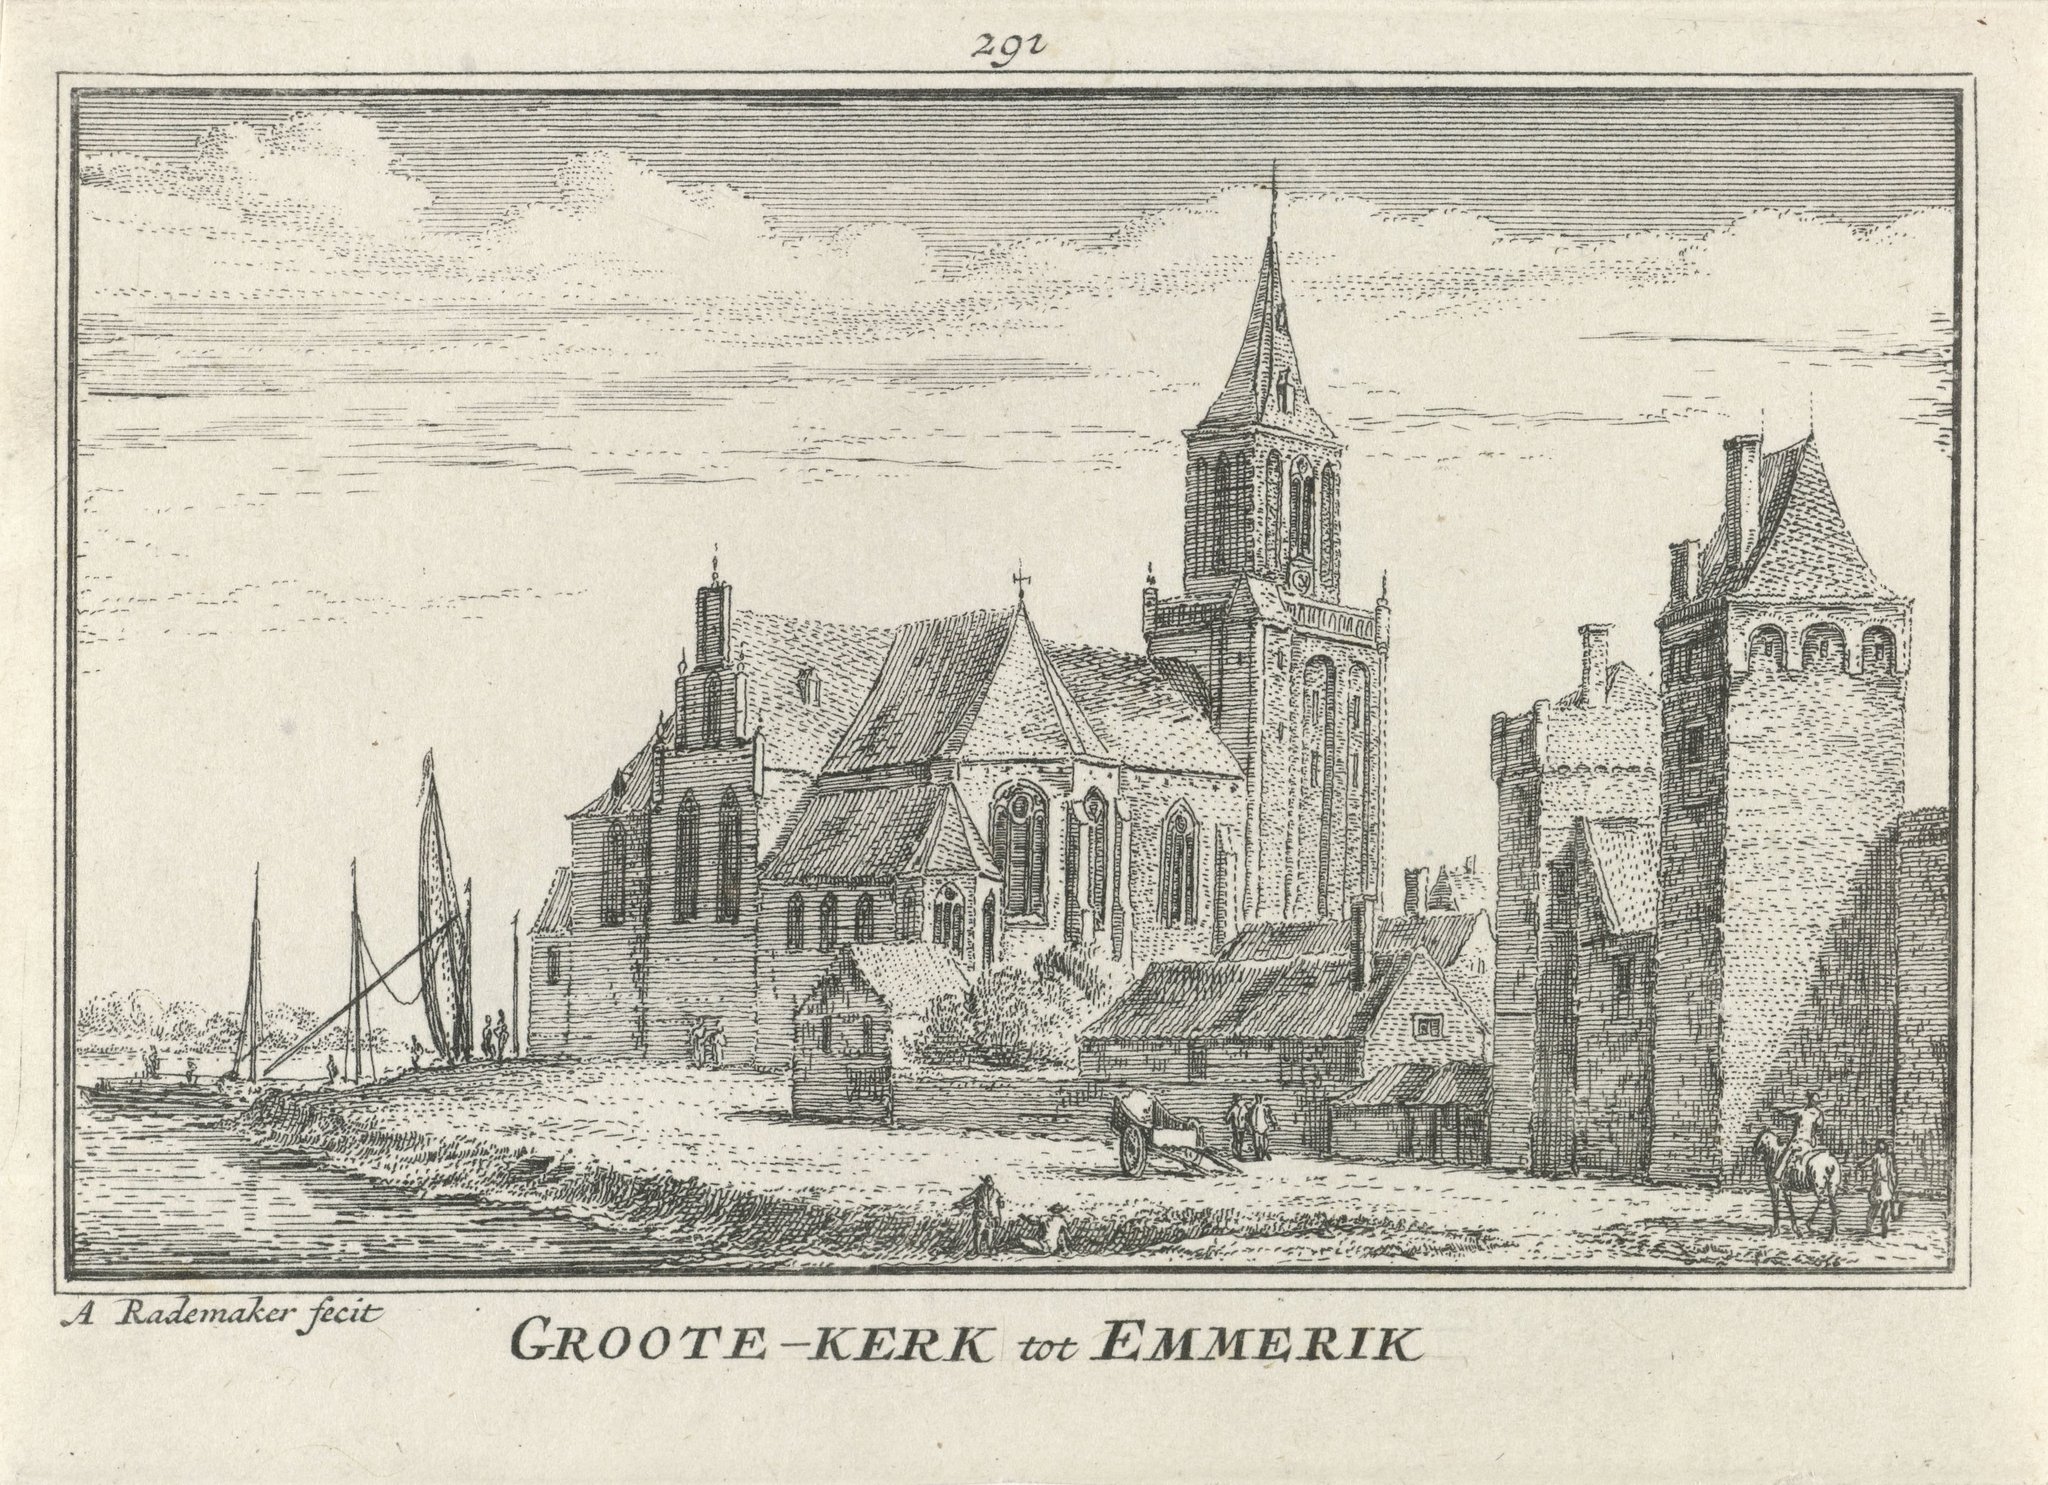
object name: book illustration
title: St. Martinikirche in Emmerik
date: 1727-1733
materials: paper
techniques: etching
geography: amsterdam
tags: church (exterior)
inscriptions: collector's mark: Lugt 2228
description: Illustratie uit: Abraham Rademaker, Matthaeus Brouërius van Niedek, Isaac Le Long, Kabinet van Nederlandsche en Kleefsche outheden en (...) voorname stads- en landgebouwen, Willem Barents en Antoni Schoonenburg: Amsterdam, 1727-1733, ill. nr. 291.